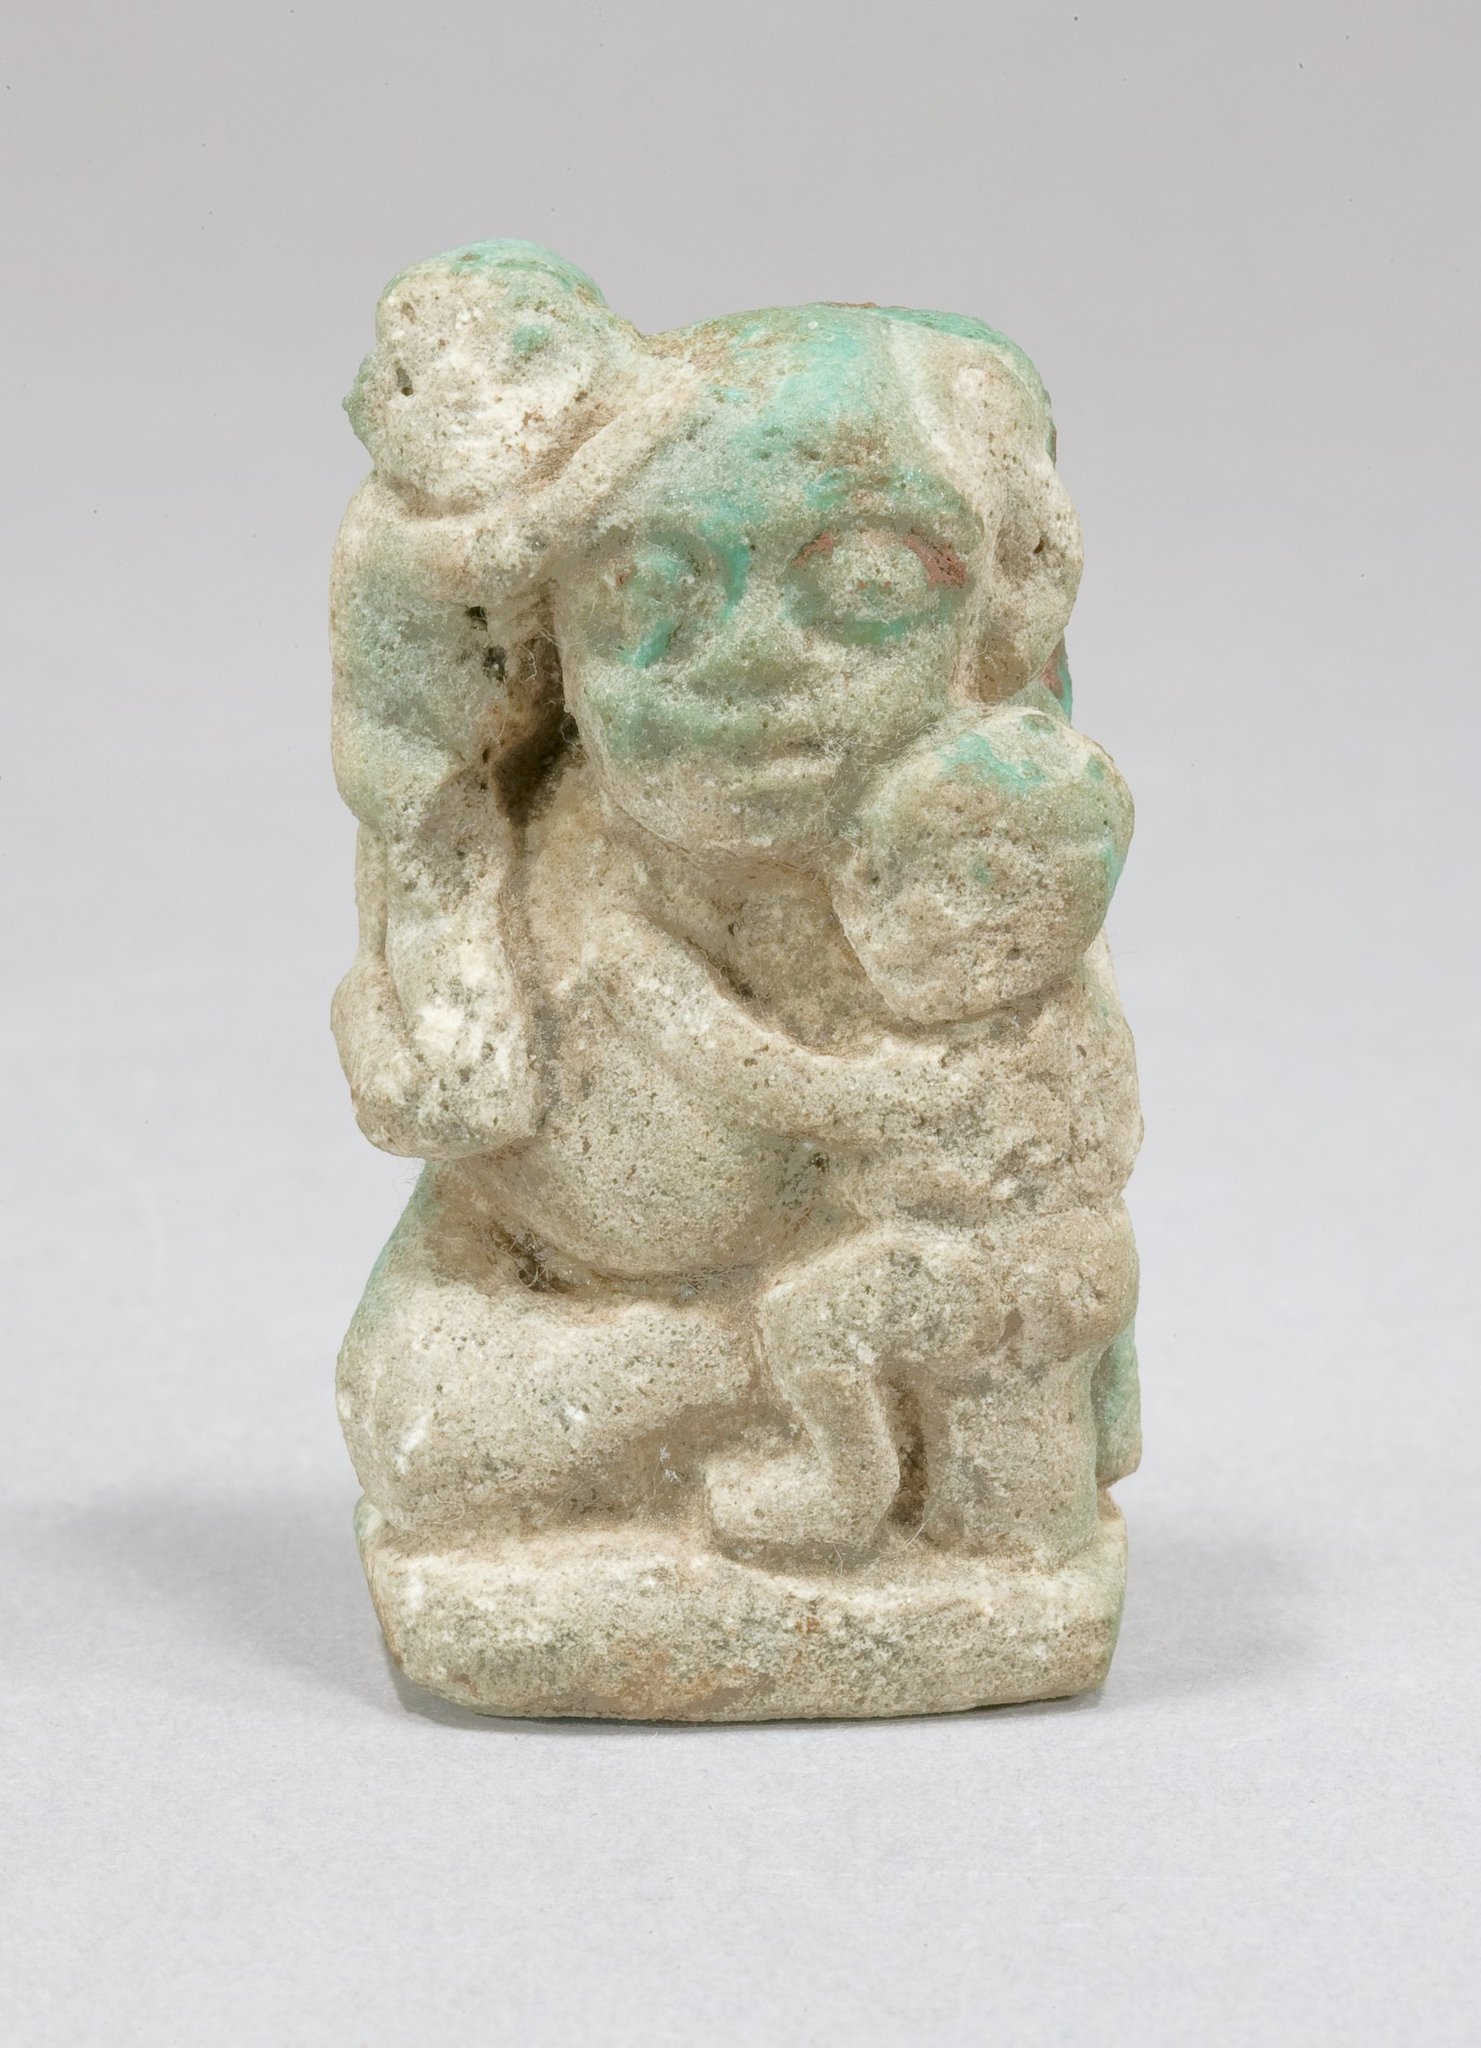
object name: figurine, female dwarf with two infant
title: Dwarf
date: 1850-1640 BCE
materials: faience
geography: egypt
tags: human figures